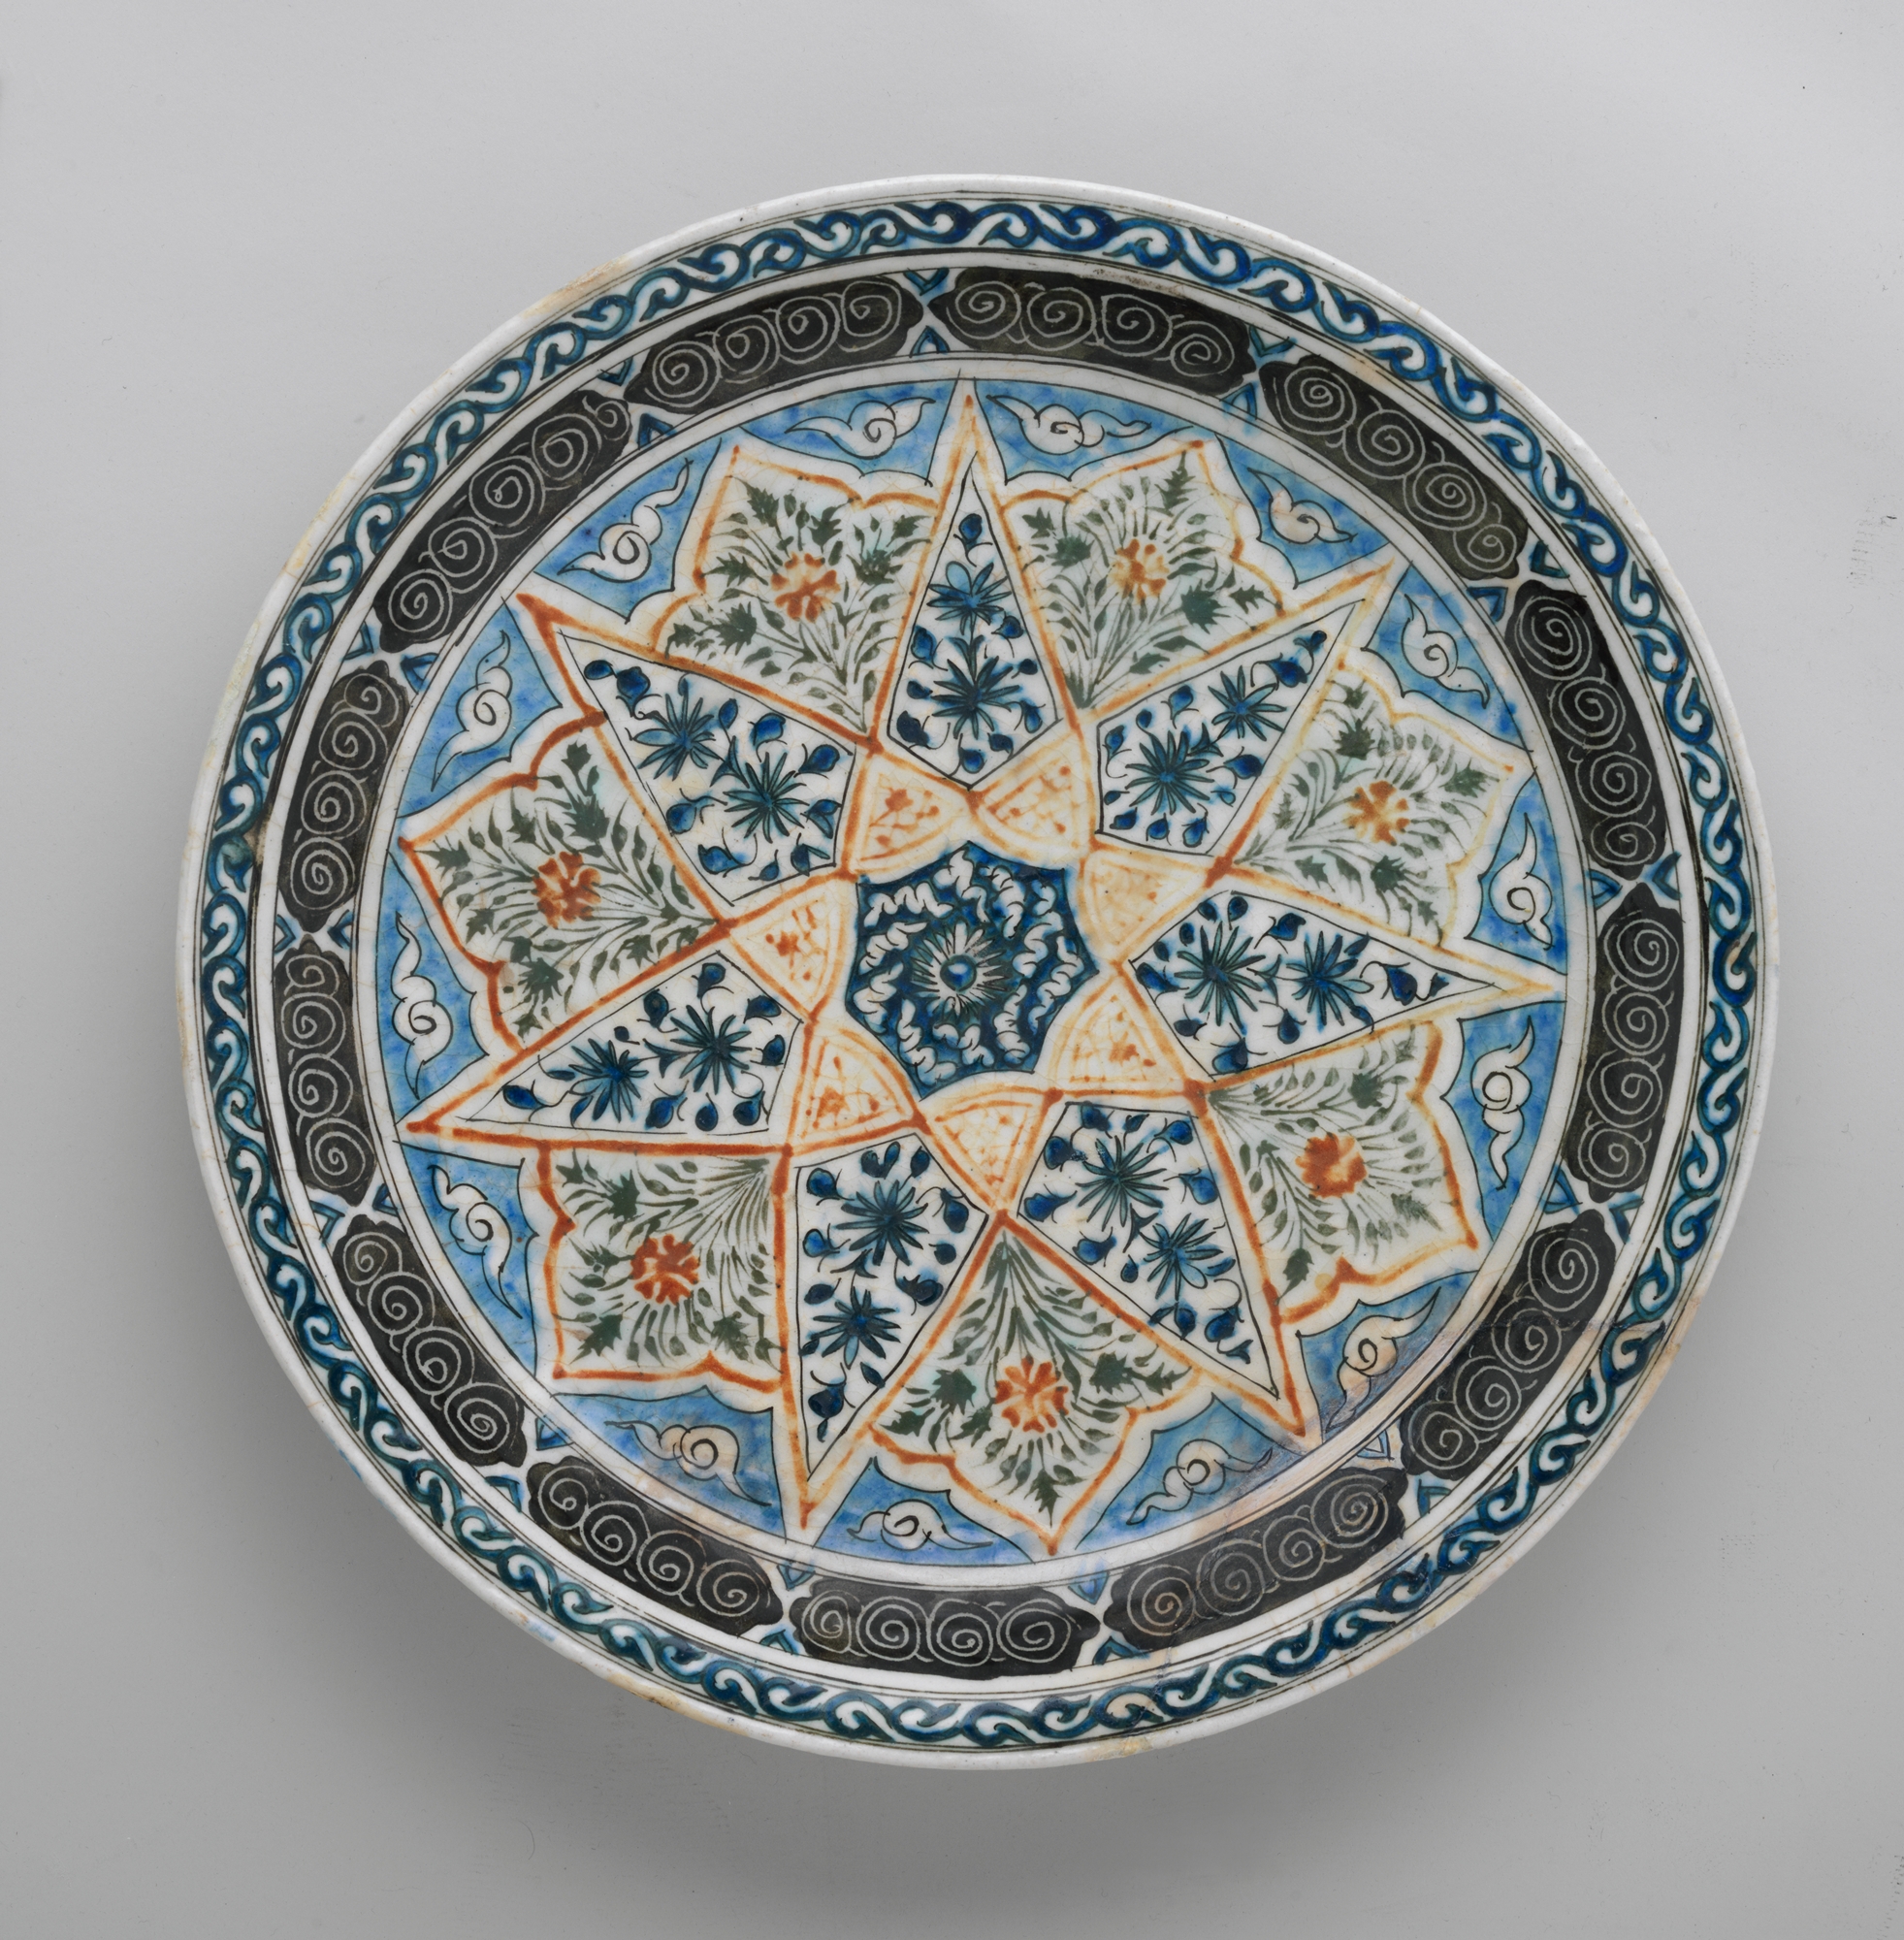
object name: plate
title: Plate with Vegetal Decoration in a Seven-pointed Star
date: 1655-1680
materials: glaze, stonepaste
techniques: painting, polychrome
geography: iran